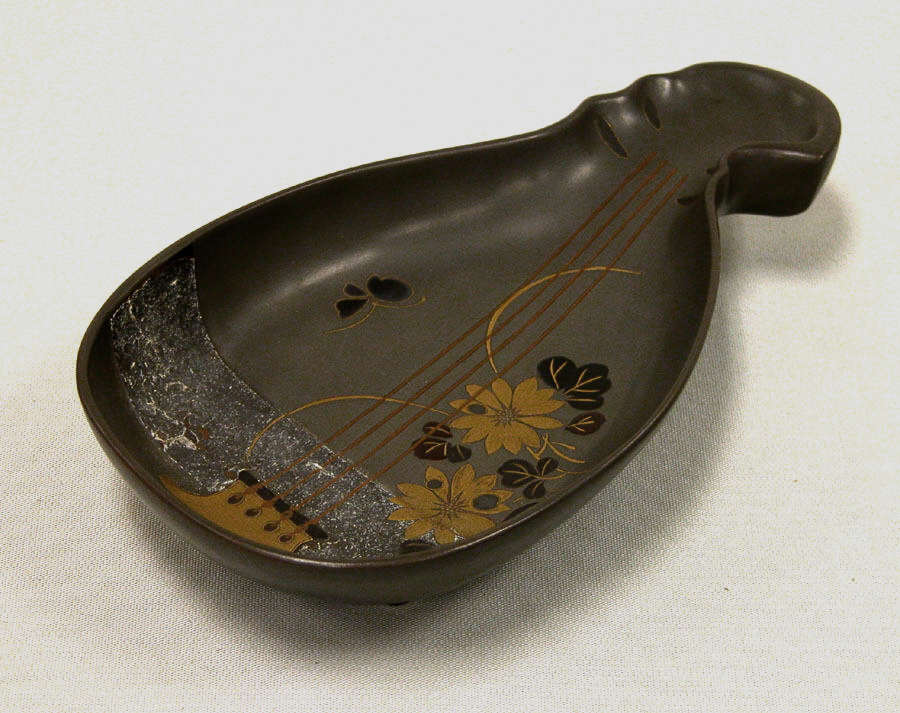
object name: tray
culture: japanese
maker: shibata zeshin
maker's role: artist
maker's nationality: japanese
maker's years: 1807-1891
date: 1801-1900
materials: gold, lacquer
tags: butterflies,flowers